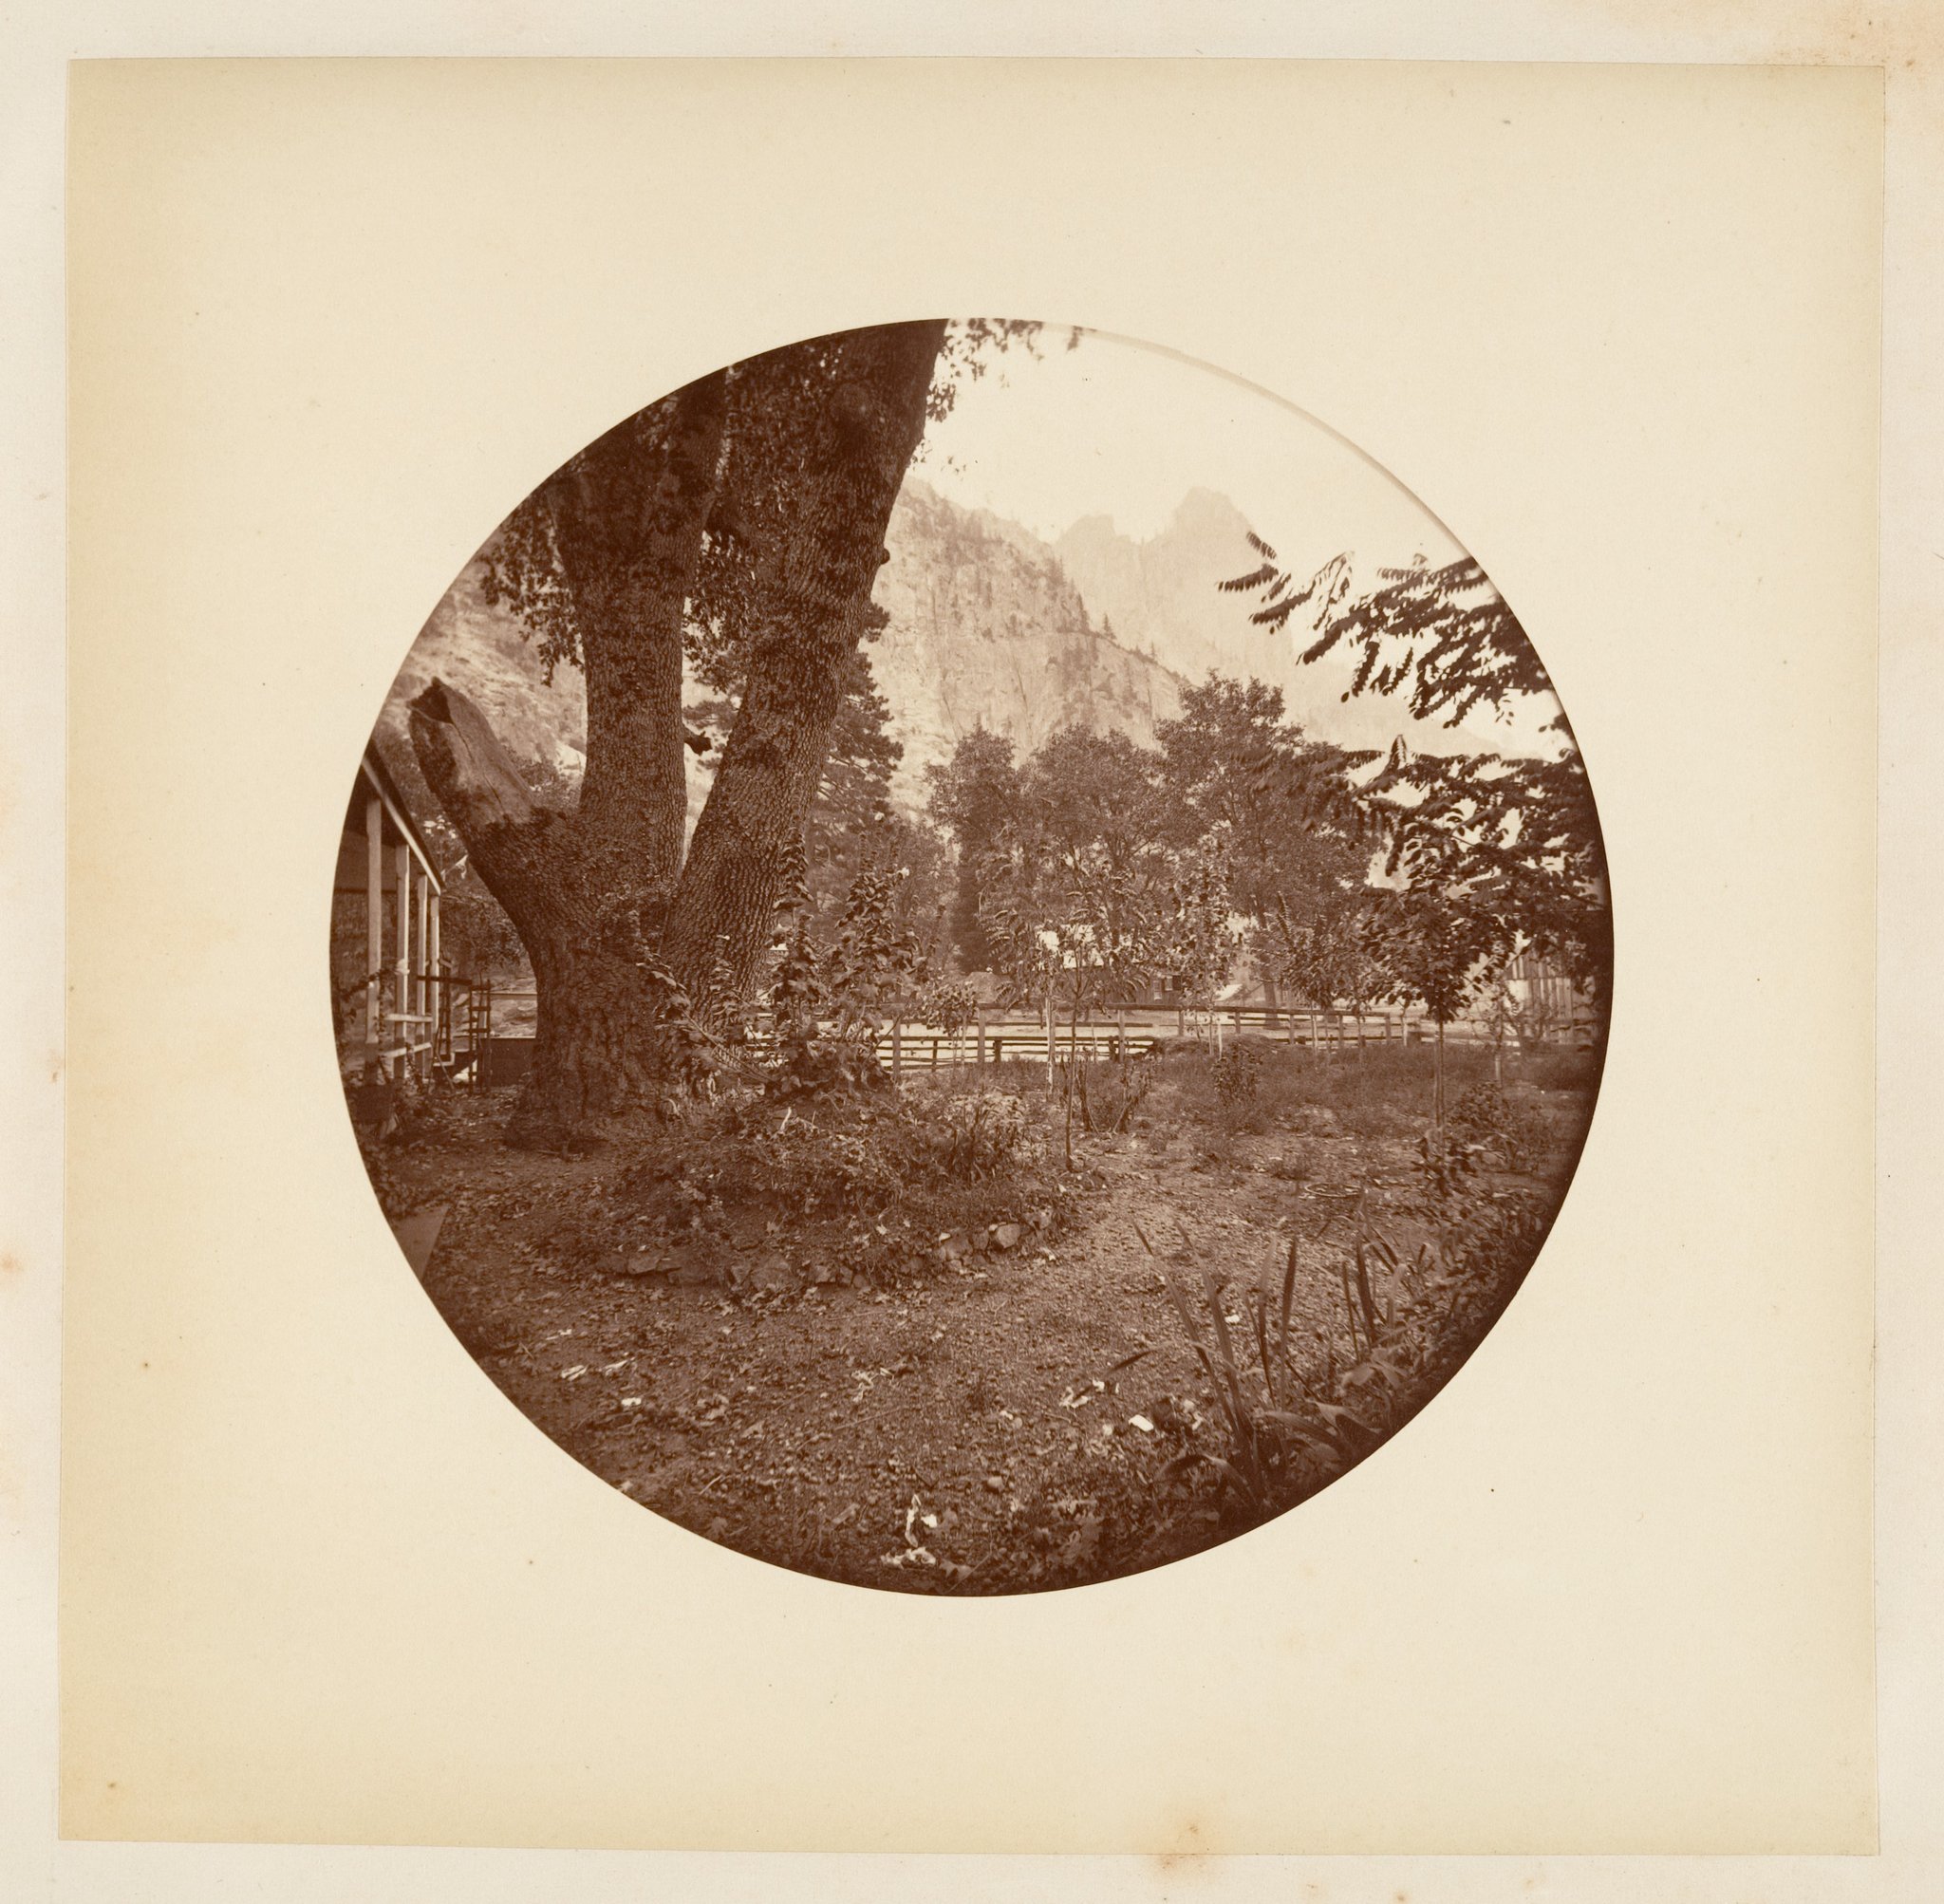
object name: photograph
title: [Yosemite National Park, California]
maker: carleton e. watkins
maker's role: artist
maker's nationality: american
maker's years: 1829-1916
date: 1878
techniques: albumen silver print, glass negative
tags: landscapes,trees